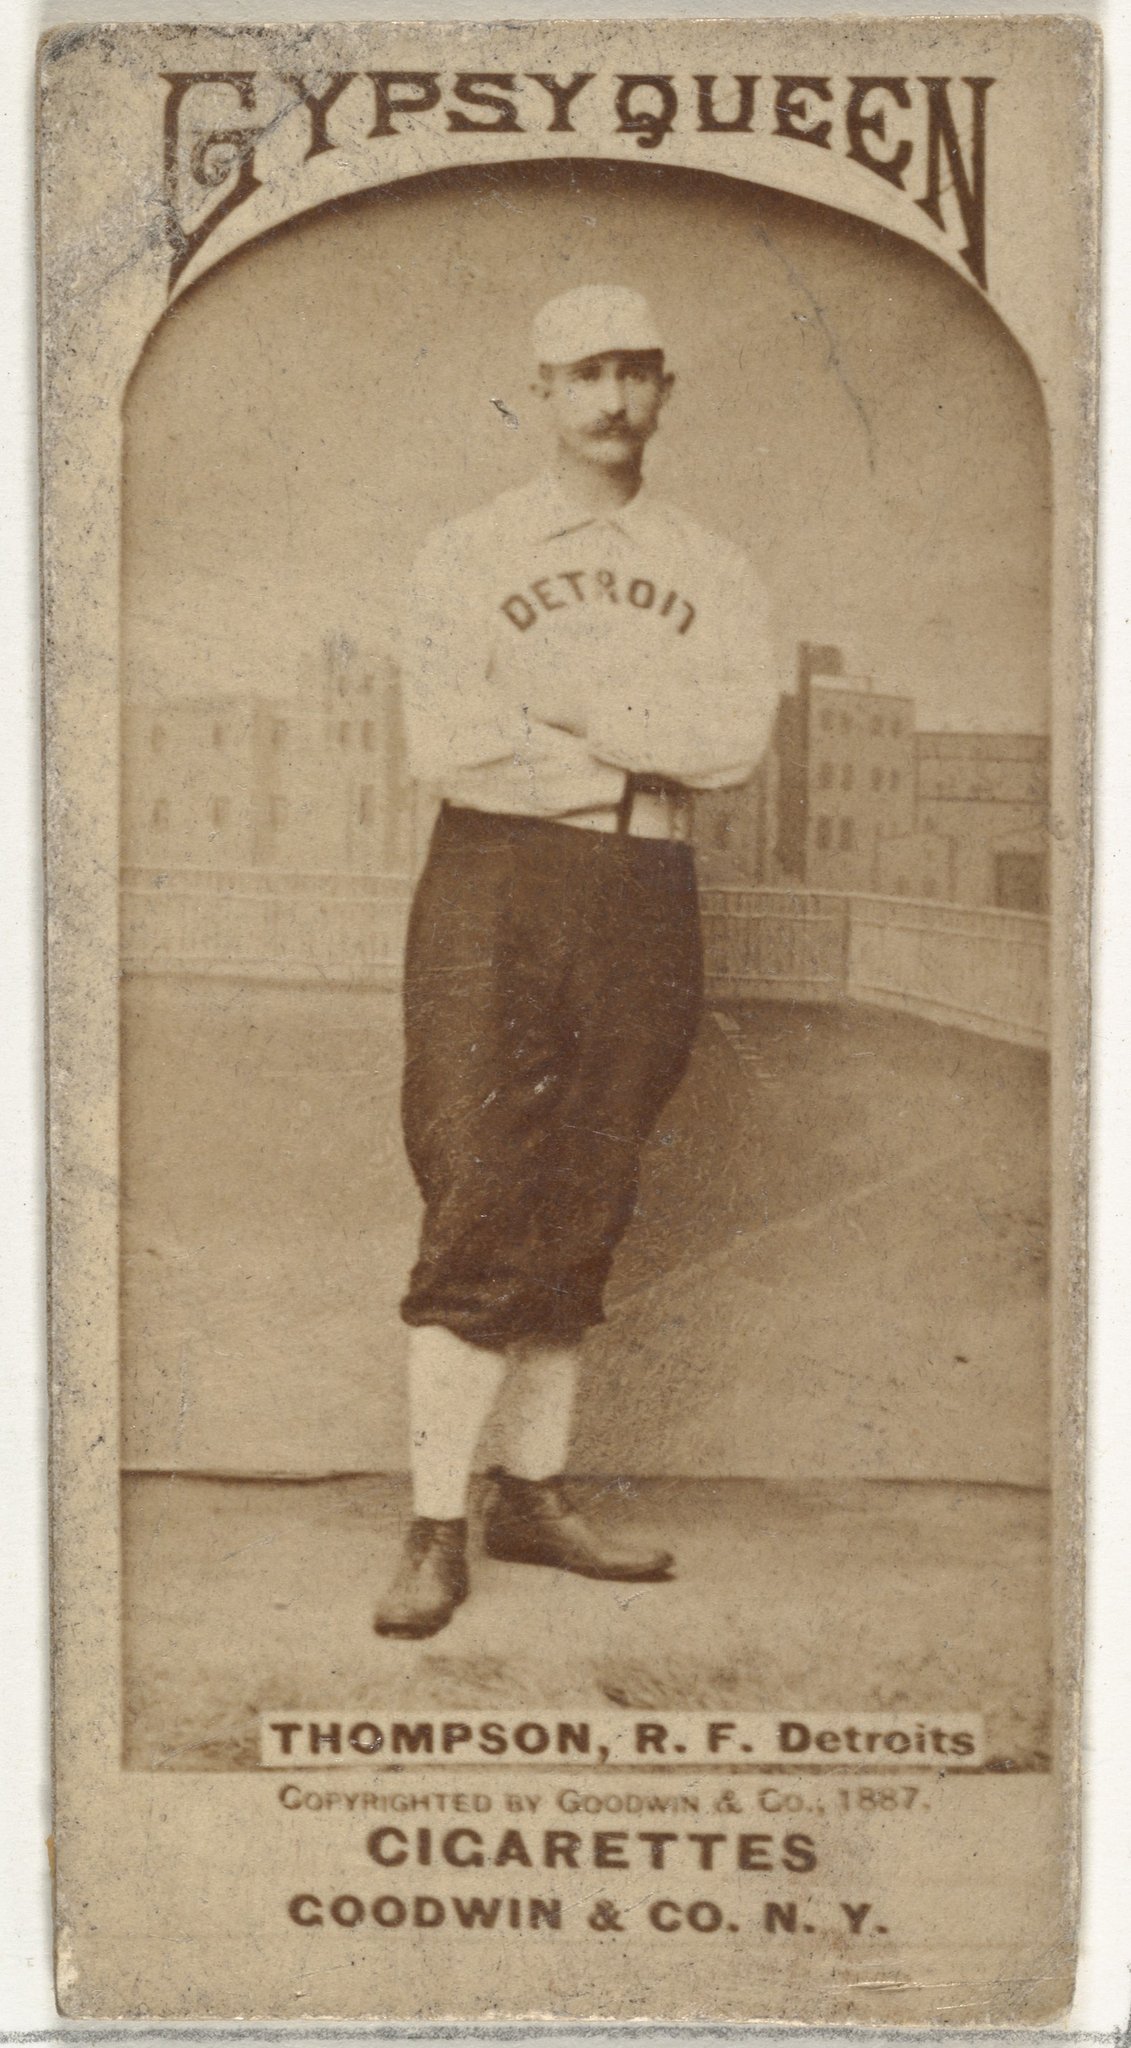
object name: baseball card, photograph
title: Samuel Luther "Sam" Thompson, Right Field, Detroit Wolverines, from the Old Judge series (N172) for Old Judge Cigarettes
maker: goodwin & company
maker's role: publisher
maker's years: 1850-1950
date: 1887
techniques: albumen silver print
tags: men,portraits,baseball,athletes